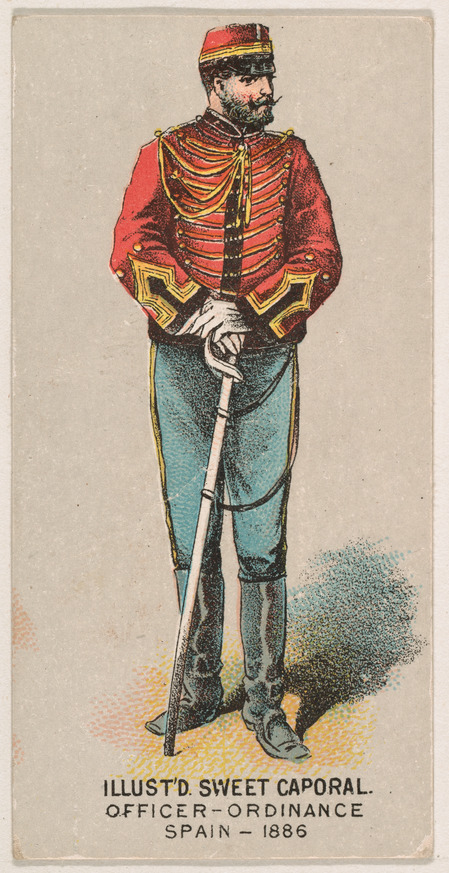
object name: print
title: Officer, Ordinance, Spain, 1886, from the Military Series (N224) issued by Kinney Tobacco Company to promote Sweet Caporal Cigarettes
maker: kinney brothers tobacco company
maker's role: publisher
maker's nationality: american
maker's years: 1869-2011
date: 1888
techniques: color lithograph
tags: military,swords,men